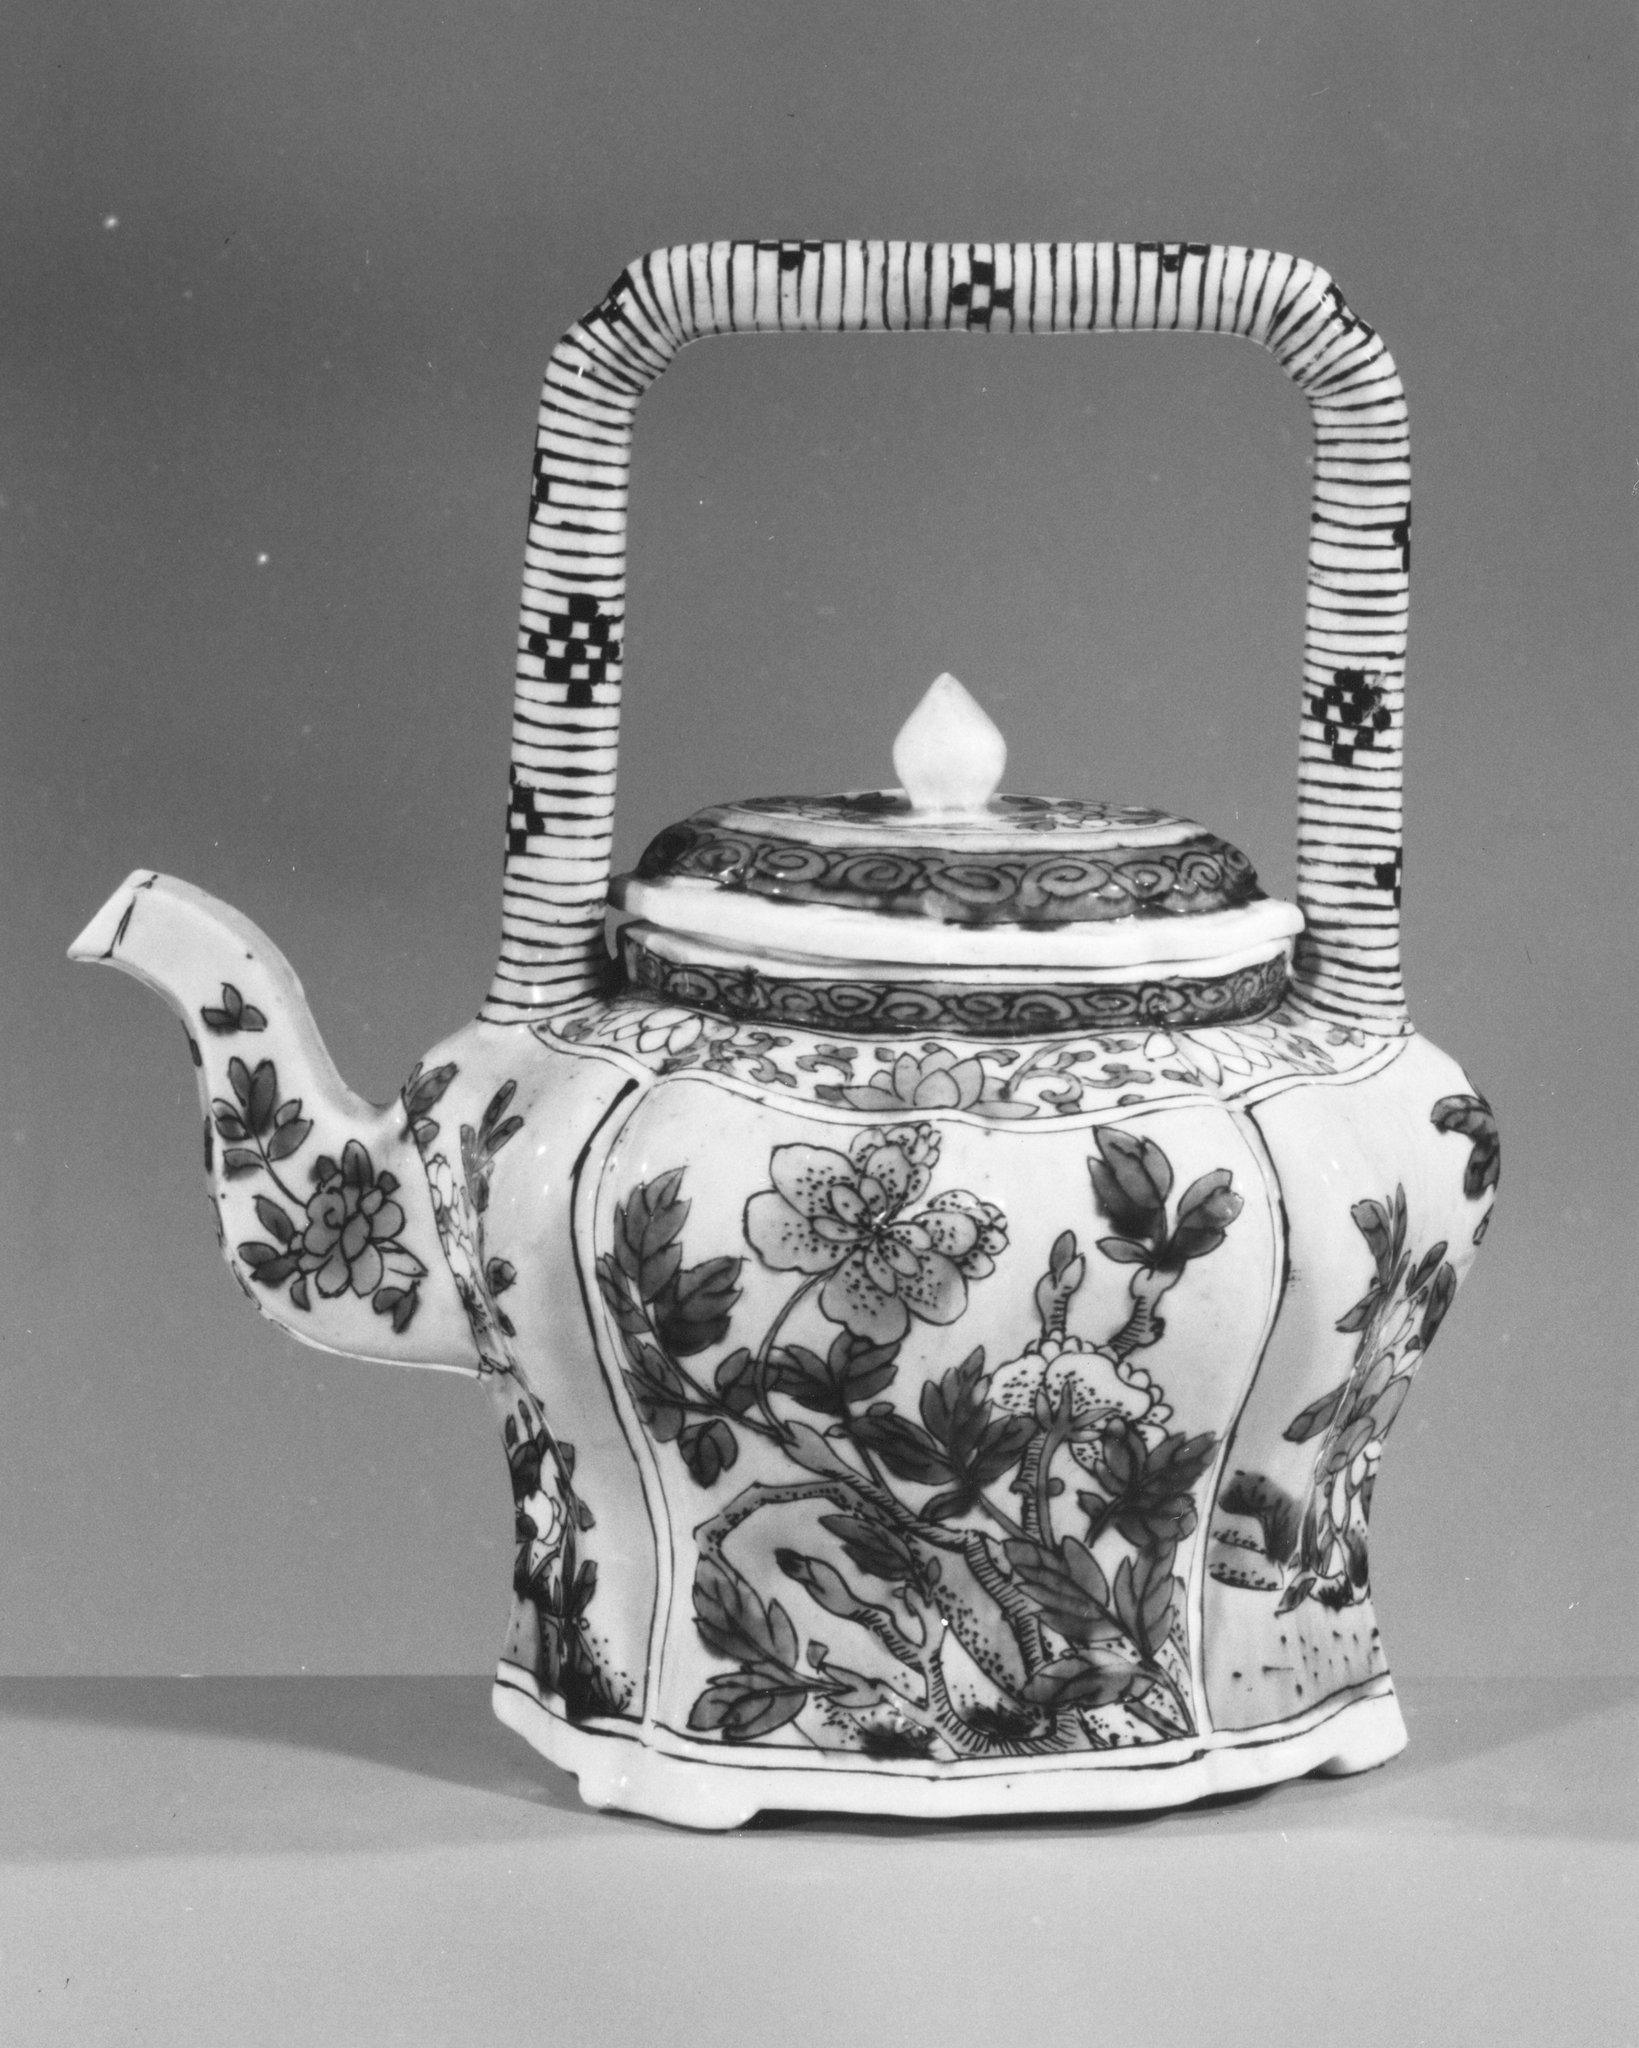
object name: winepot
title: Winepot with Cover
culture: chinese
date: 1667-1733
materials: biscuit, enamel, porcelain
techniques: painting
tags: flowers